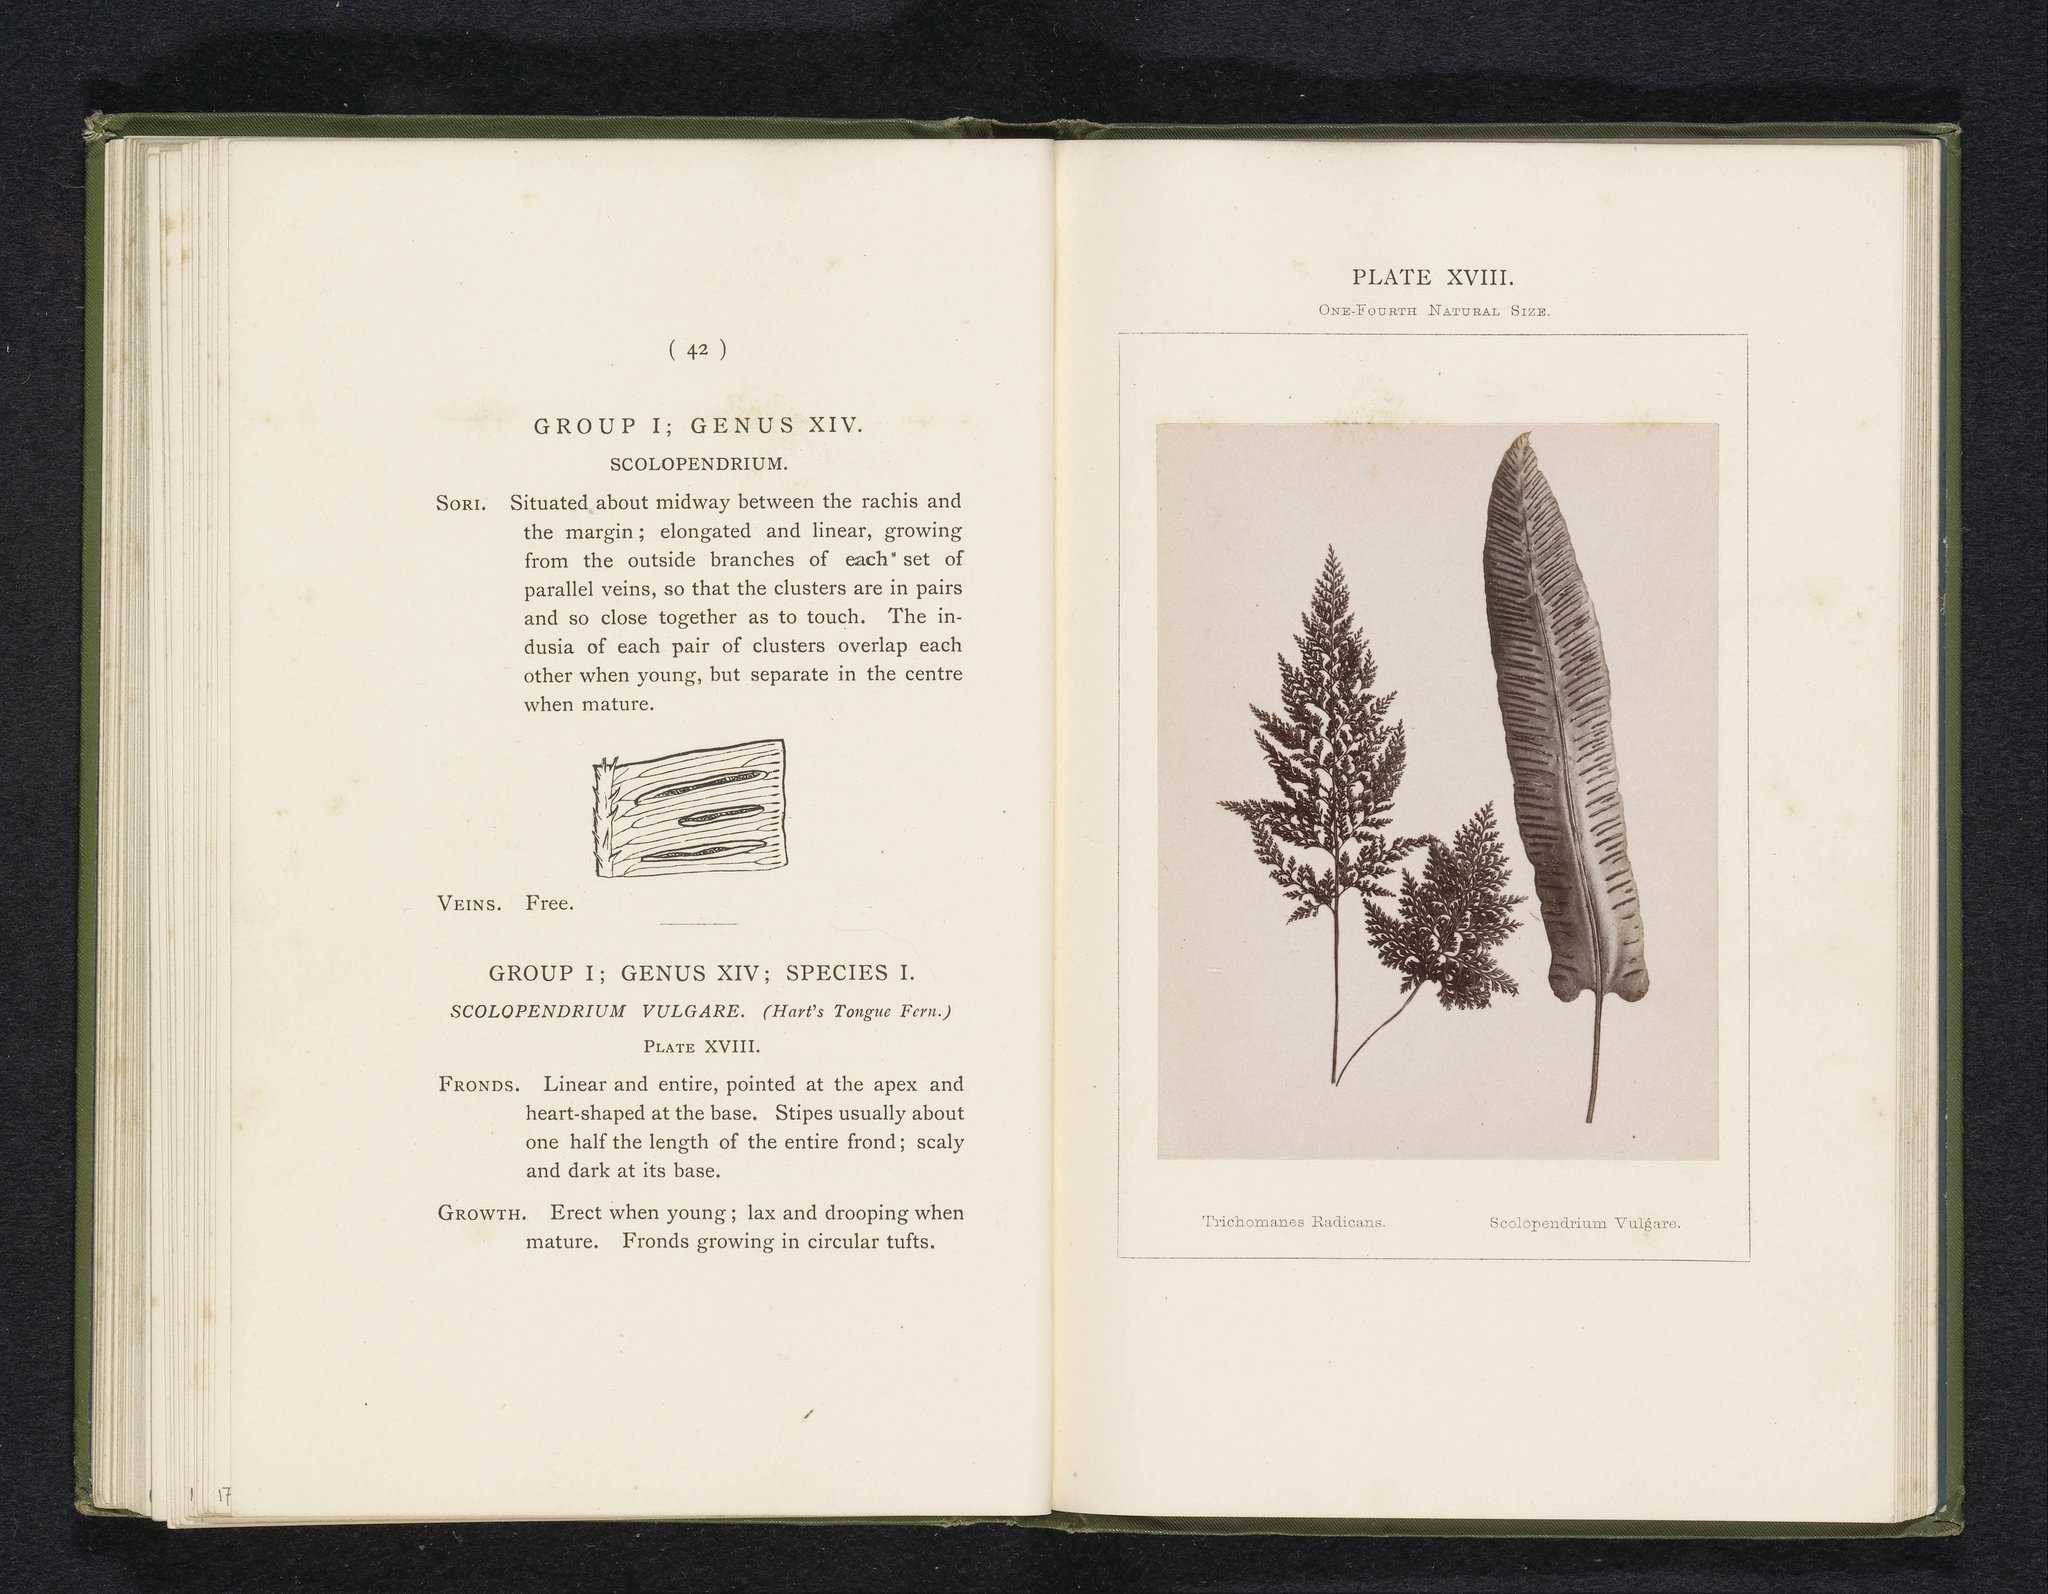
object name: page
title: Trichomanes Radicans. Scolopendrium Vulgare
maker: sydney courtauld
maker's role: botanicus, fotograaf, schrijver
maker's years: 1840-1899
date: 1867-1877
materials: photographic support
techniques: albumen print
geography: england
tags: ferns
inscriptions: inscription: ‘Plate XVIII. One-fourth natural size.’